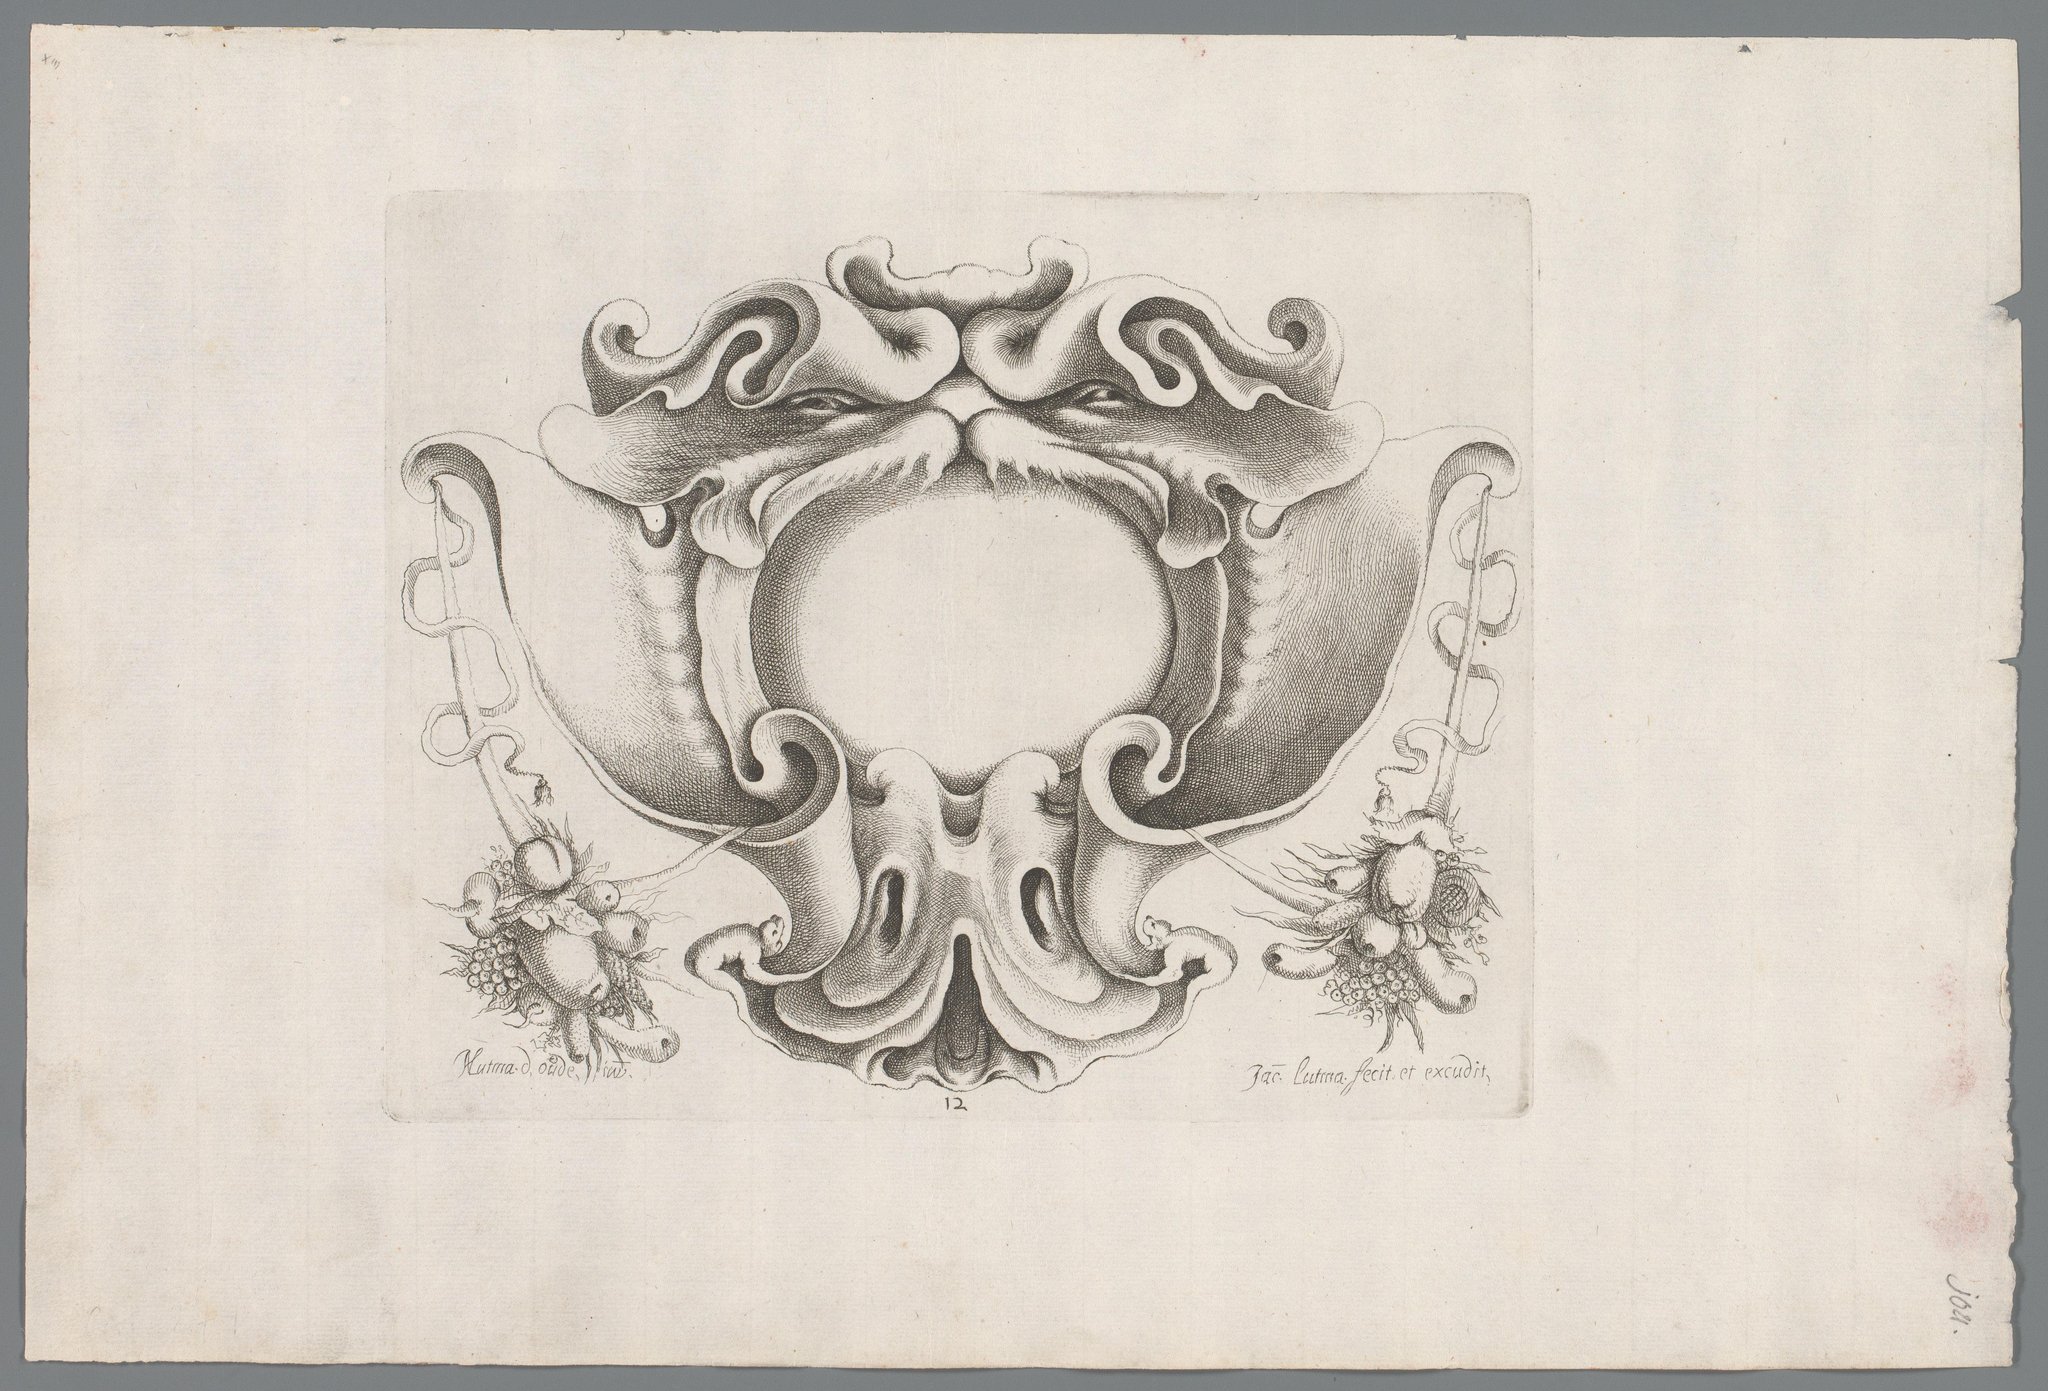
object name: print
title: Cartouche in kwabstijl rond de open bek van een monster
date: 1654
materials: paper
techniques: engraving, etching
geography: amsterdam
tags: auricular ornament, lobe style ~ ornament, fruits and vegetables ~ ornament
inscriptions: collector's mark: Lugt 2760, collector's mark: Lugt 2228